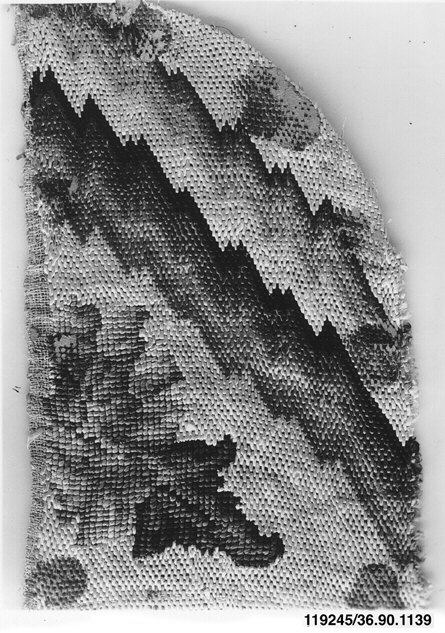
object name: piece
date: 1701-1800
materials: cotton, silk